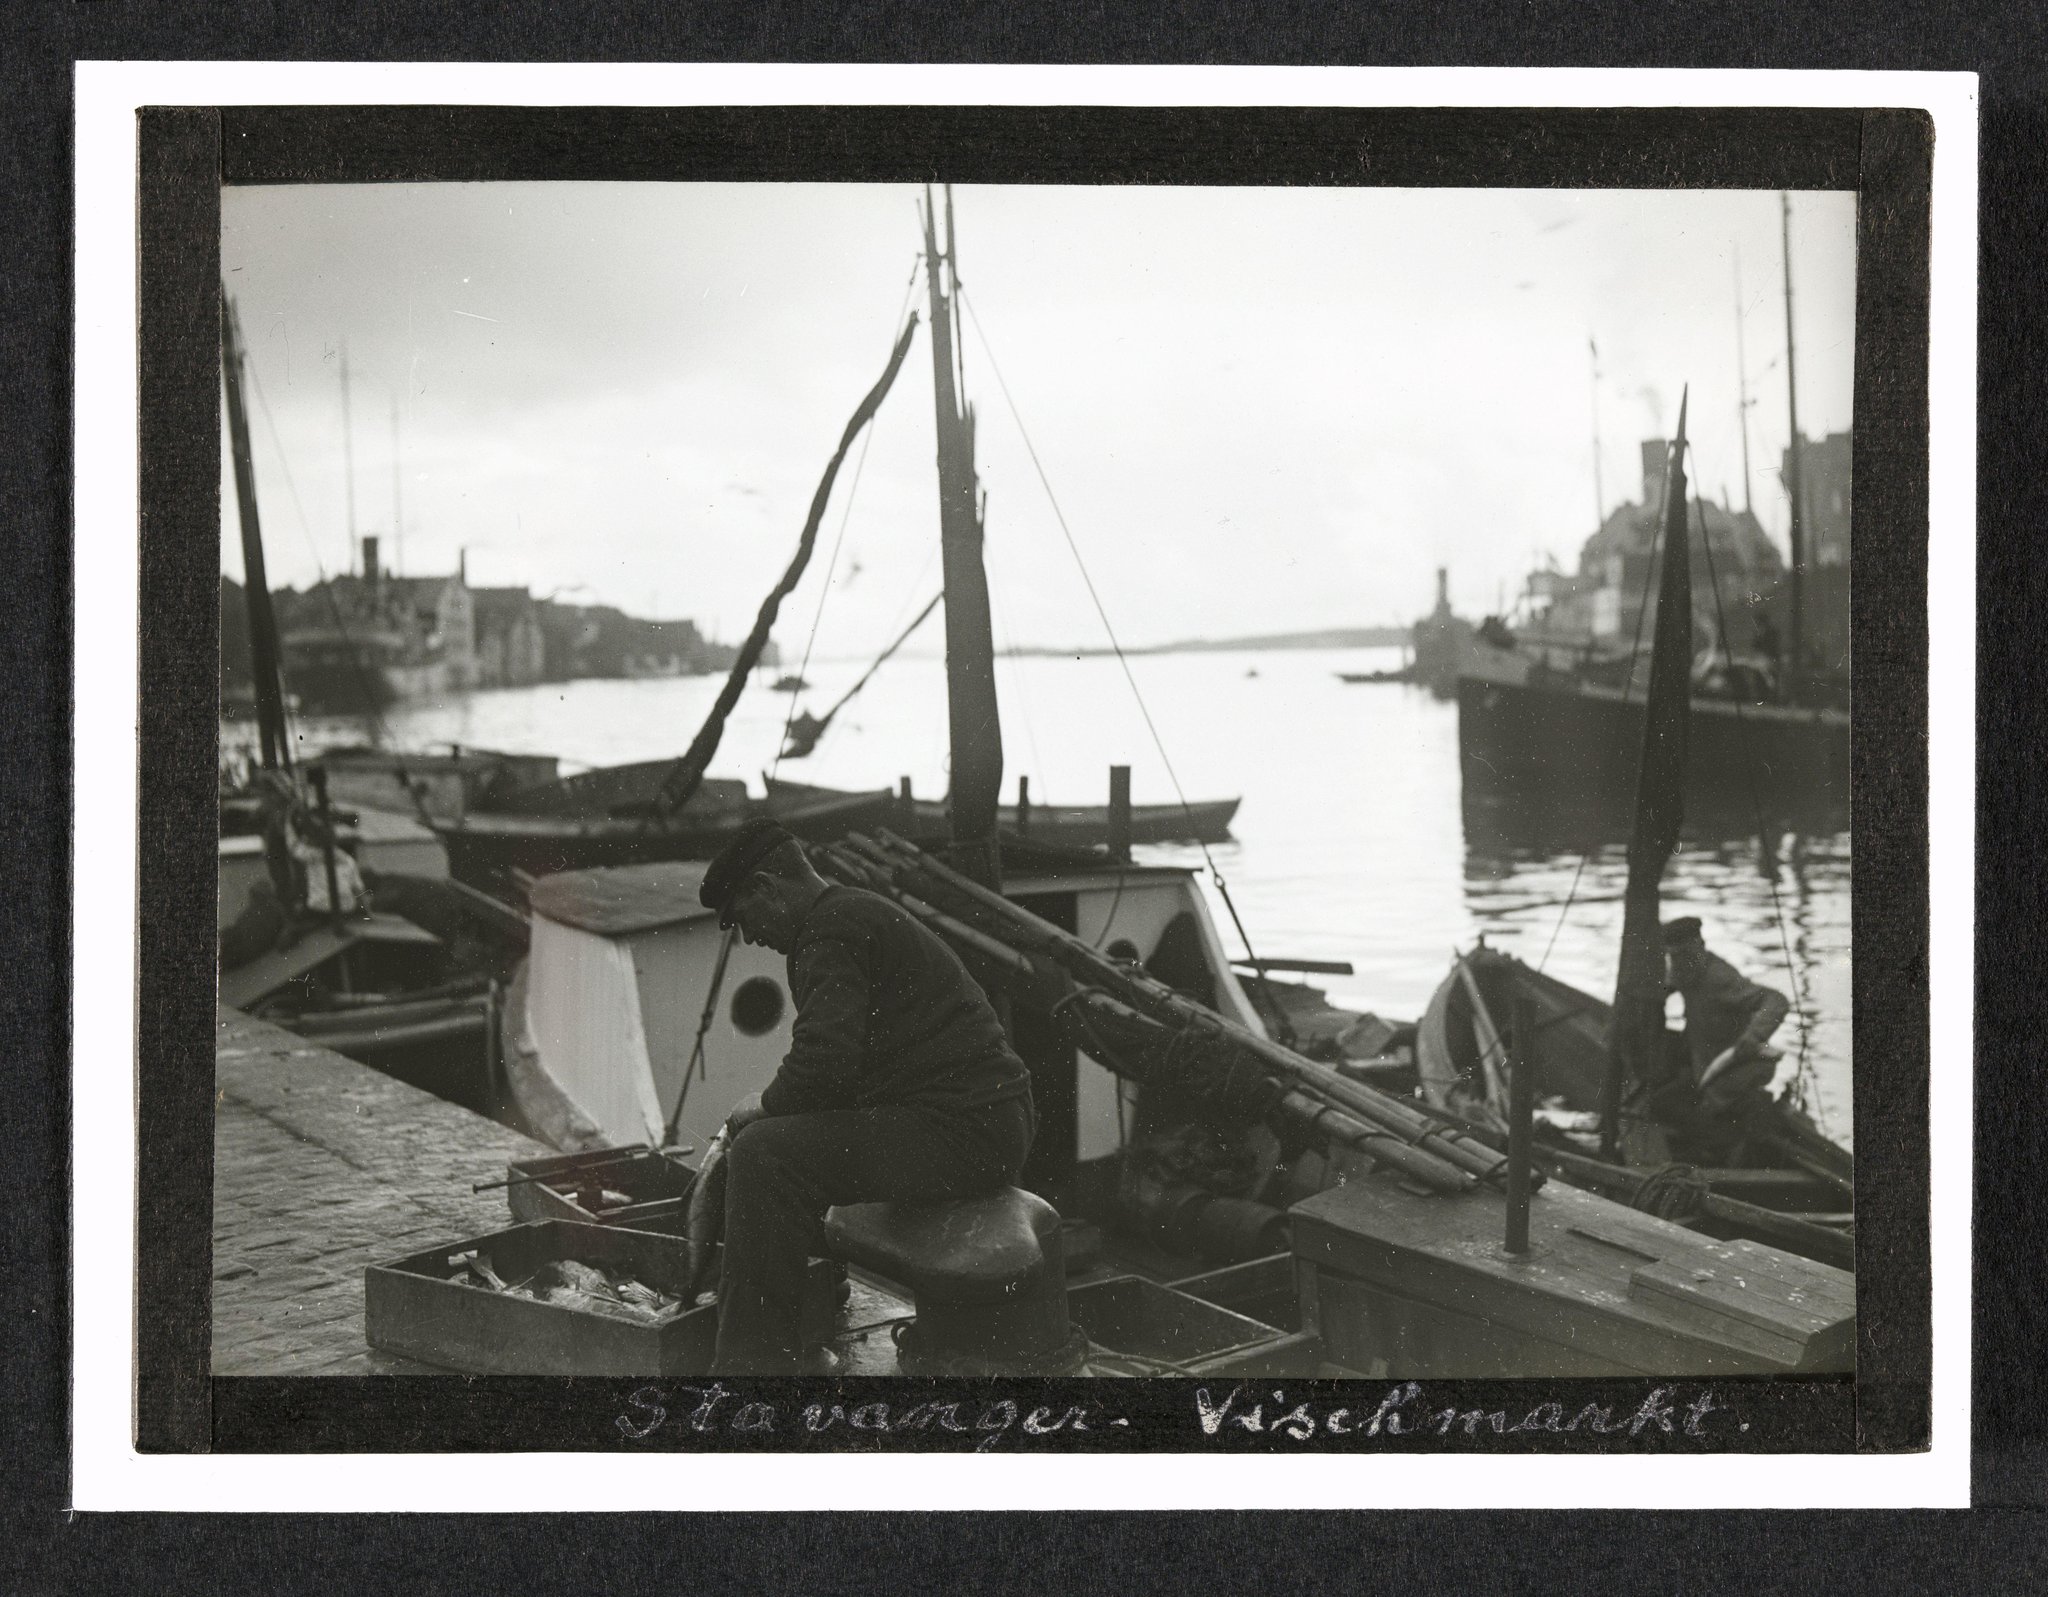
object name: photograph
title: Stavanger. Vischmarkt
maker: Anonymous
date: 1907-1935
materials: glass, ink, paper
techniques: slide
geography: stavanger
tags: harbour, fisherman